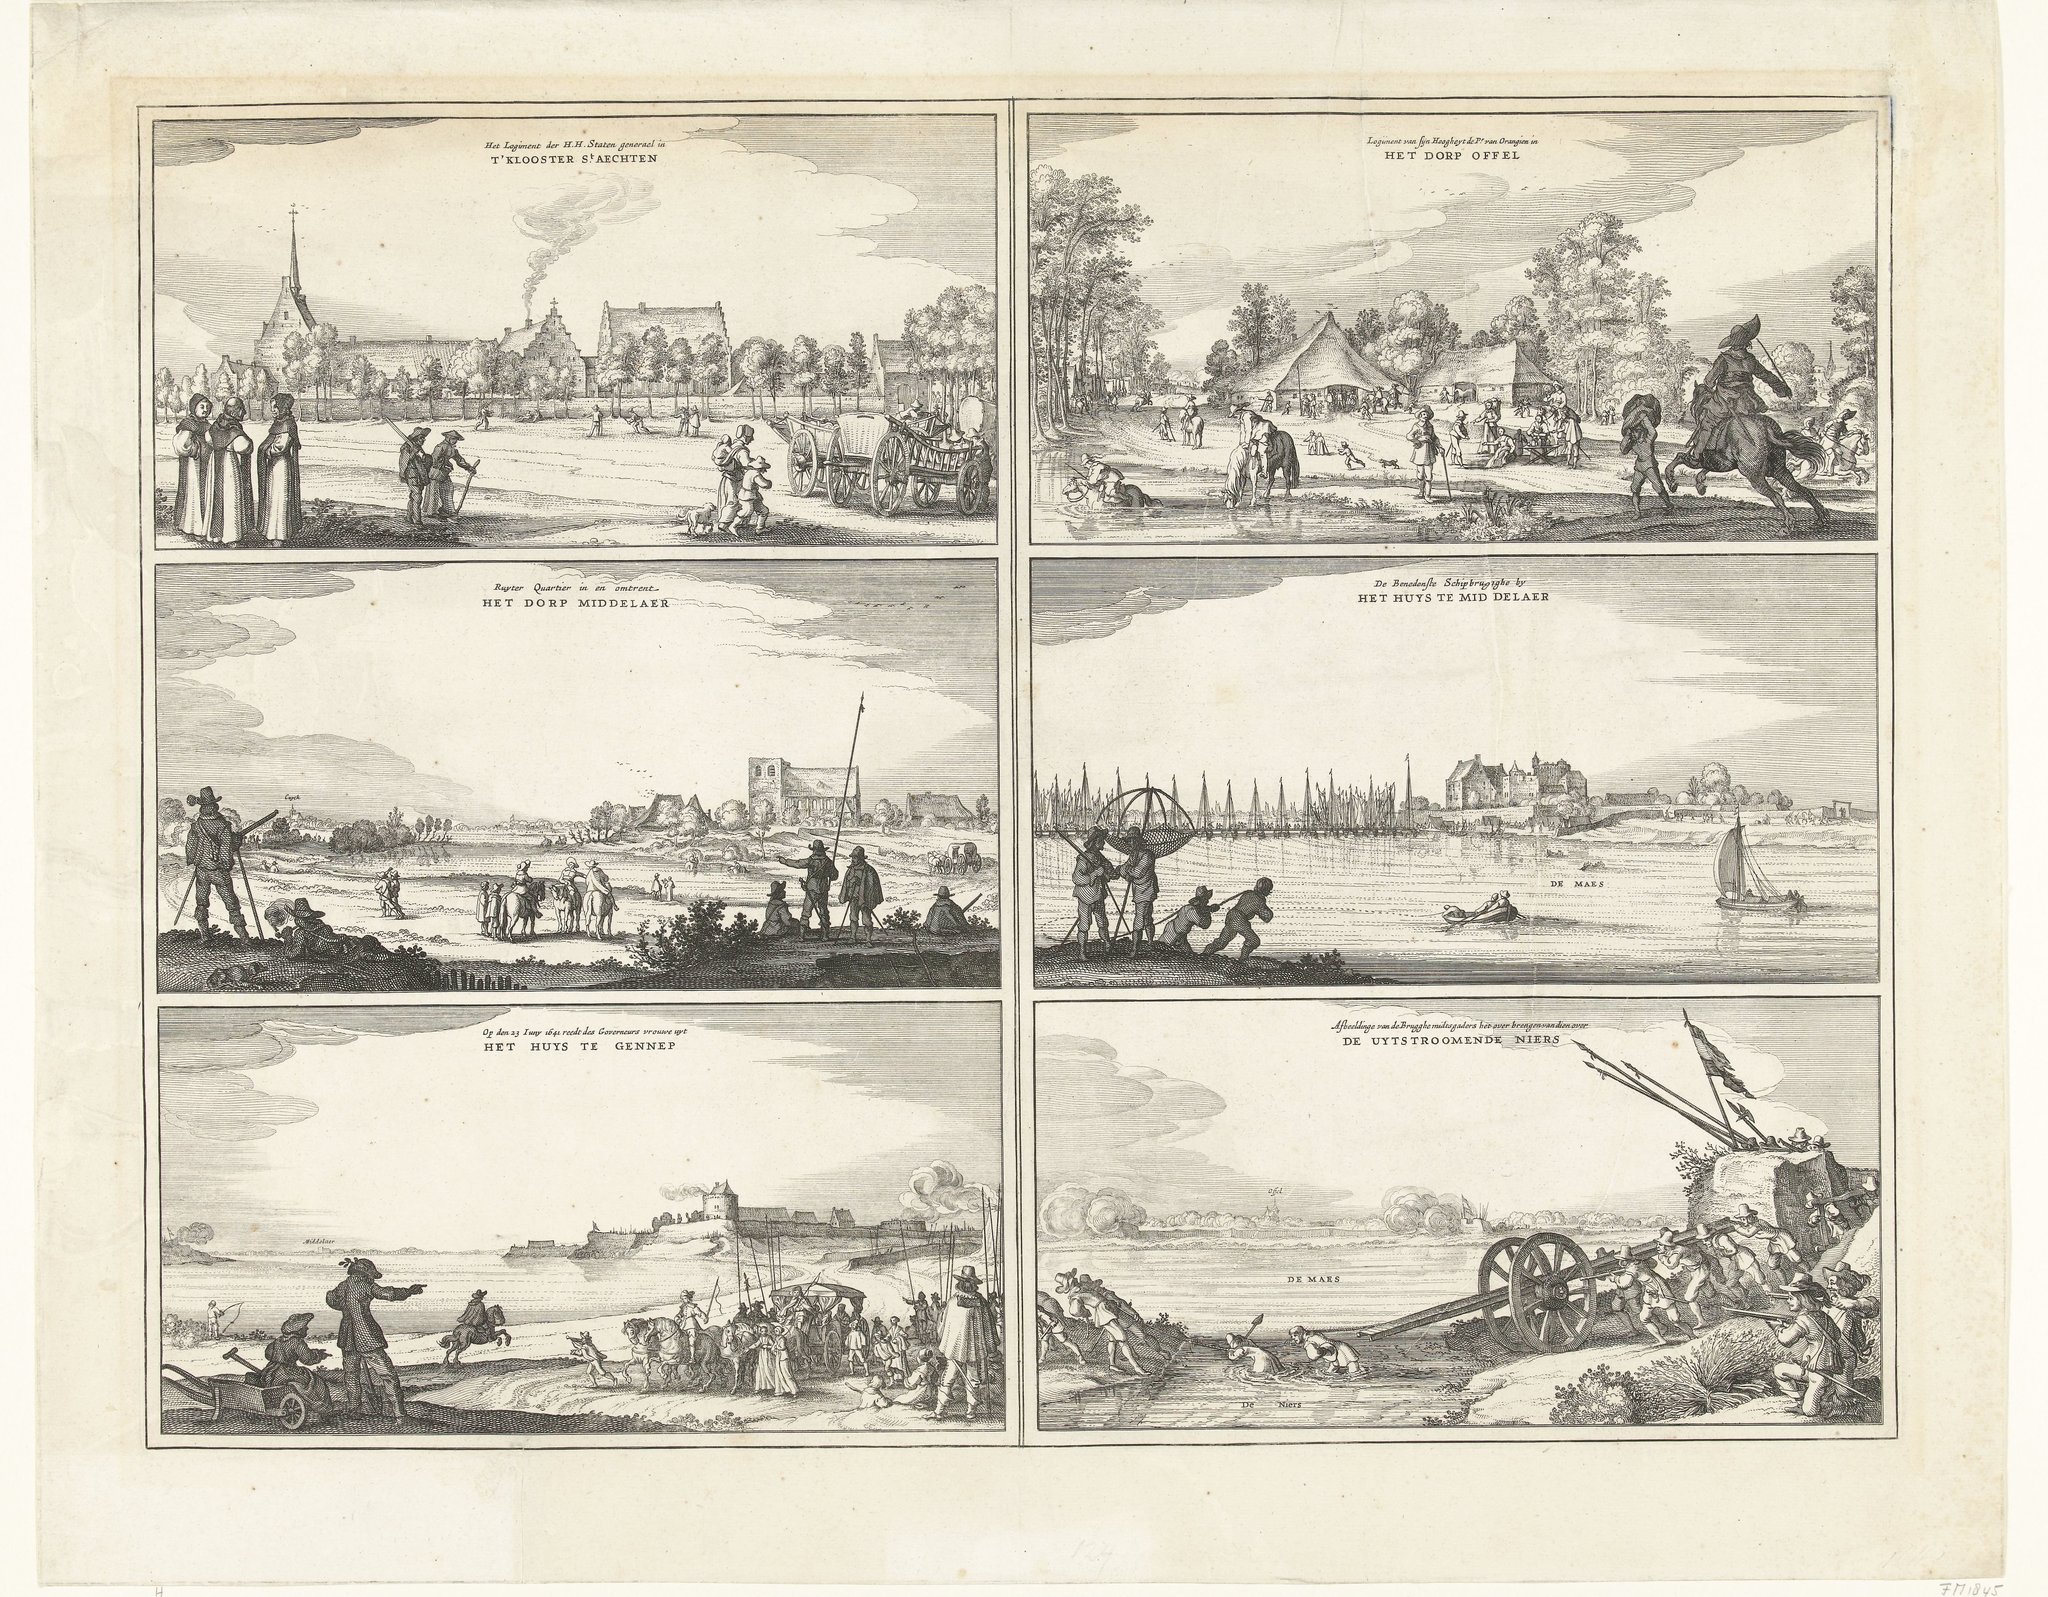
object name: print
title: Zes scènes tijdens het beleg van Huis te Gennep, 1641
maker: claes jansz. visscher (ii)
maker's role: draughtsman, print maker, publisher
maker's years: 1586-1652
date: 1641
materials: paper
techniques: etching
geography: amsterdam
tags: delft, the hague, frederick henry (prince of orange), siege, position war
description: Blad met zes scènes van afzonderlijke gebeurtenissen in de nabije omgeving tijdens het beleg van het Huis te Gennep door het Staatse leger onder Frederik Hendrik, 6 juni - 27 juli 1641. Onderdeel van een ensemble bestaande uit een titel in 4 stroken, de 4 platen uit het atelier van Visscher, de 4 bladen van het vertrek van het garnizoen door Nolpe en 7 tekstbladen.